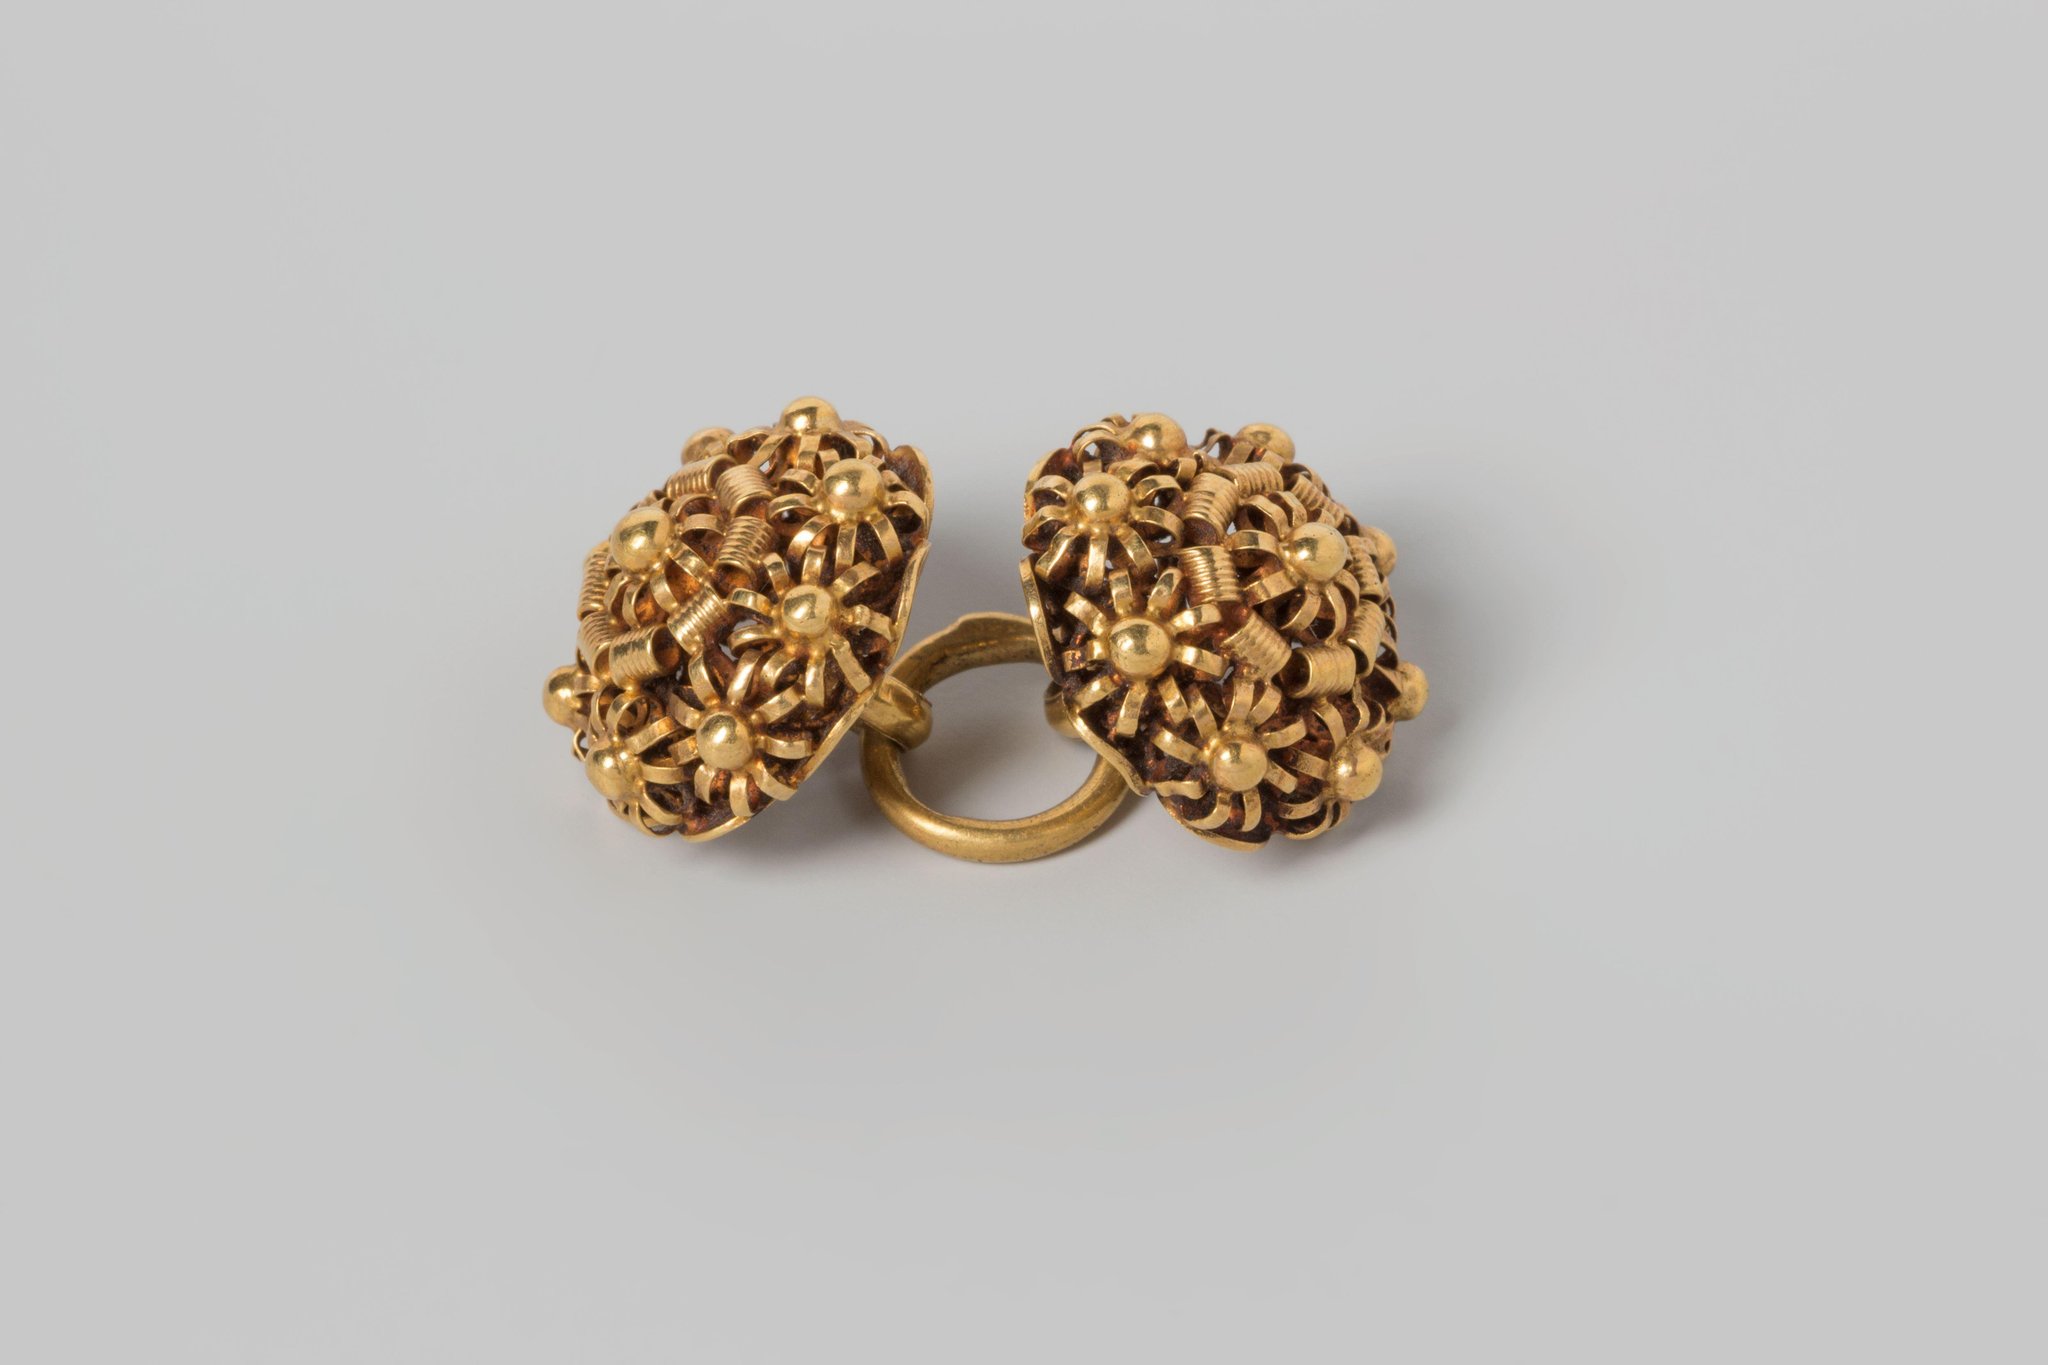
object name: button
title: Hemdsknopen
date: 1750-1850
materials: gold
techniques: filigree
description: Twee gouden hemdsknopen van filigrein. Aan elkaar vast.